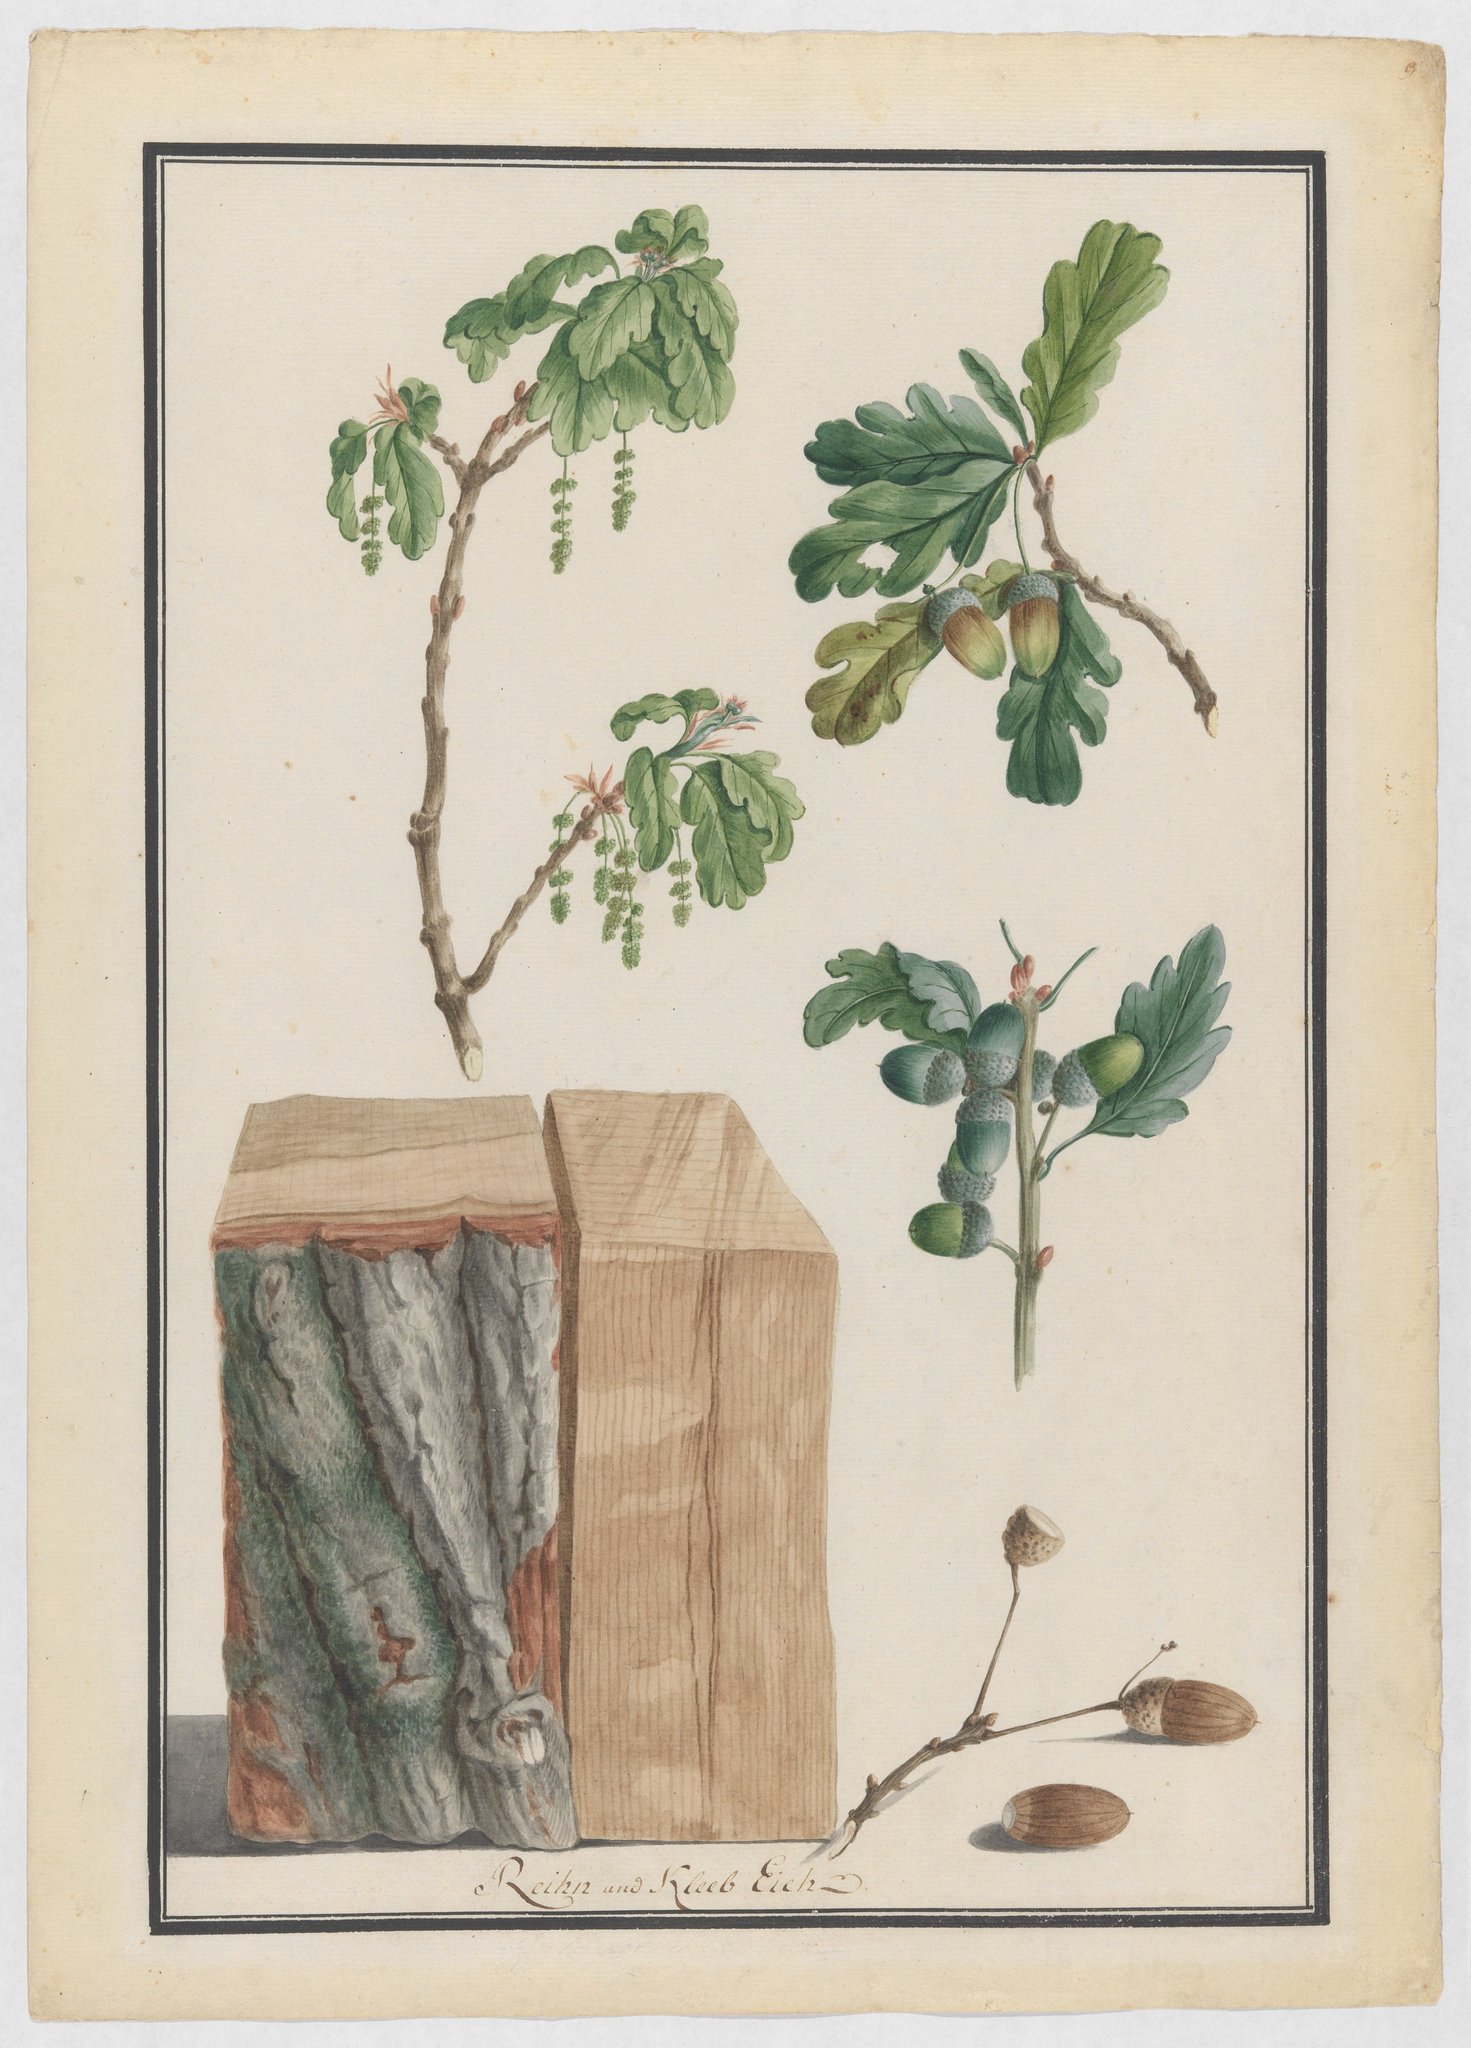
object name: drawing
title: Studies of the blossoms, fruits and trunk of an English oak (Quercus robur)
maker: ludwig pfleger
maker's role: artist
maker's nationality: german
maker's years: 1720-1793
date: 1788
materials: chalk, ink, watercolor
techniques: pen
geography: germany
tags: fruit,oaks